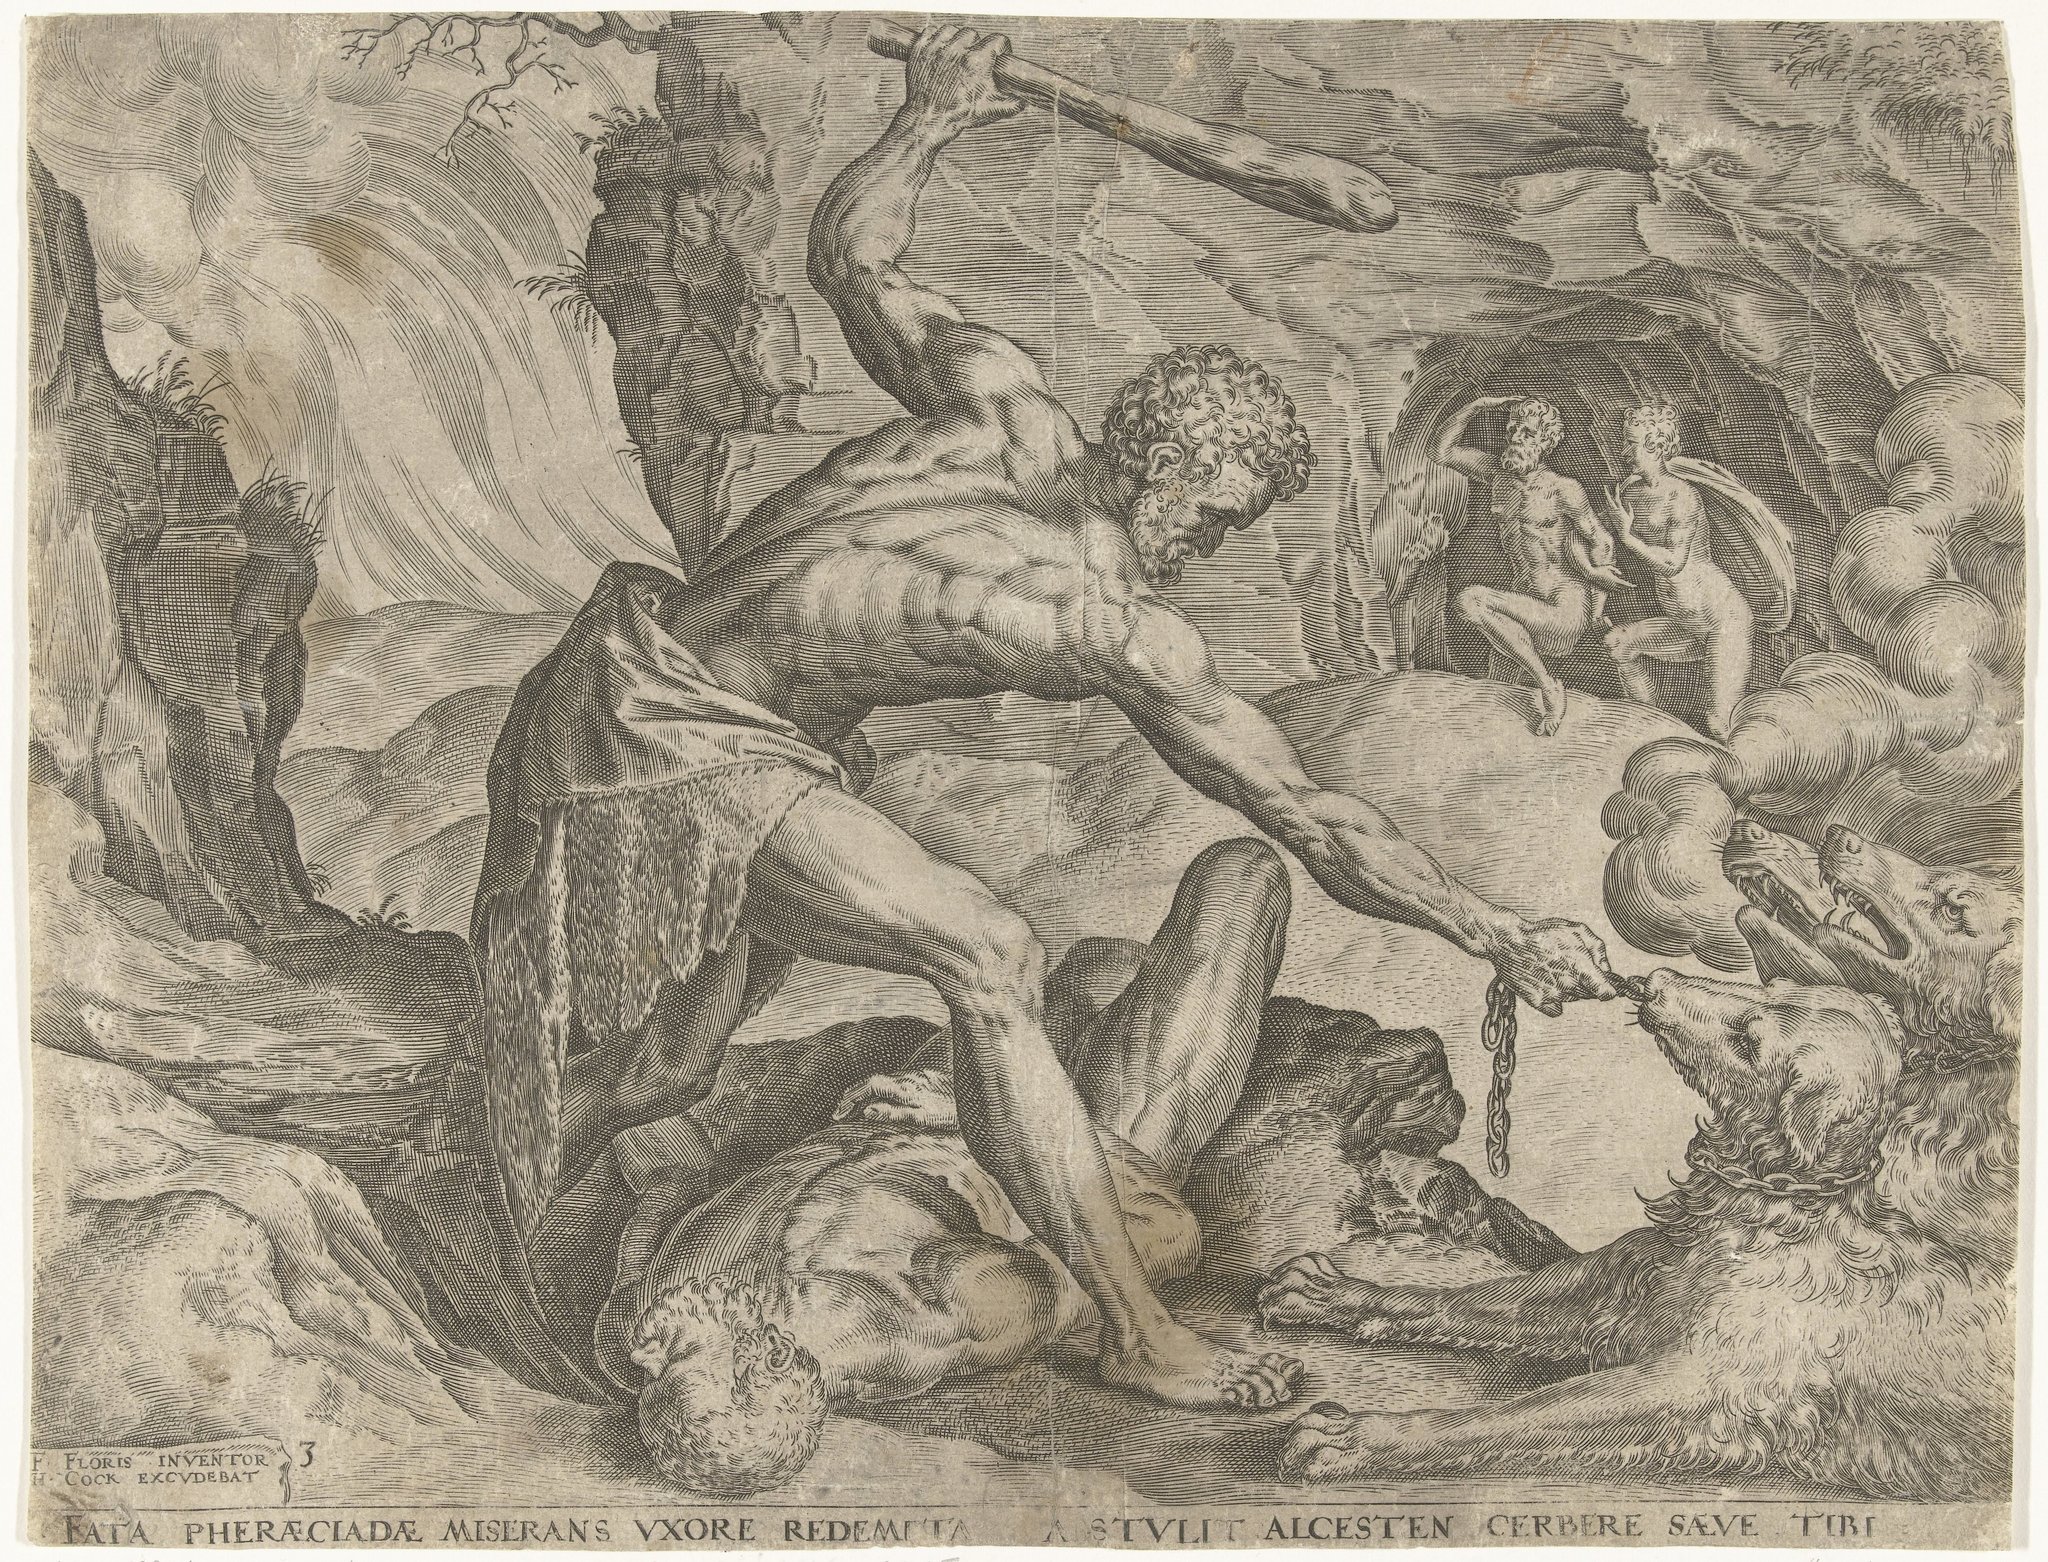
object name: print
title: Werken van Hercules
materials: paper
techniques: etching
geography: antwerp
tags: (12) cerberus captured and carried away by hercules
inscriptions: collector's mark: Lugt 2228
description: Hercules neemt Cerberus, de drie-koppige hond die de ingang van de Hades bewaakt, mee de hel uit. Hij trekt aan de ketting om Cerberus hoofden en bedreigt de hond met zijn knots.